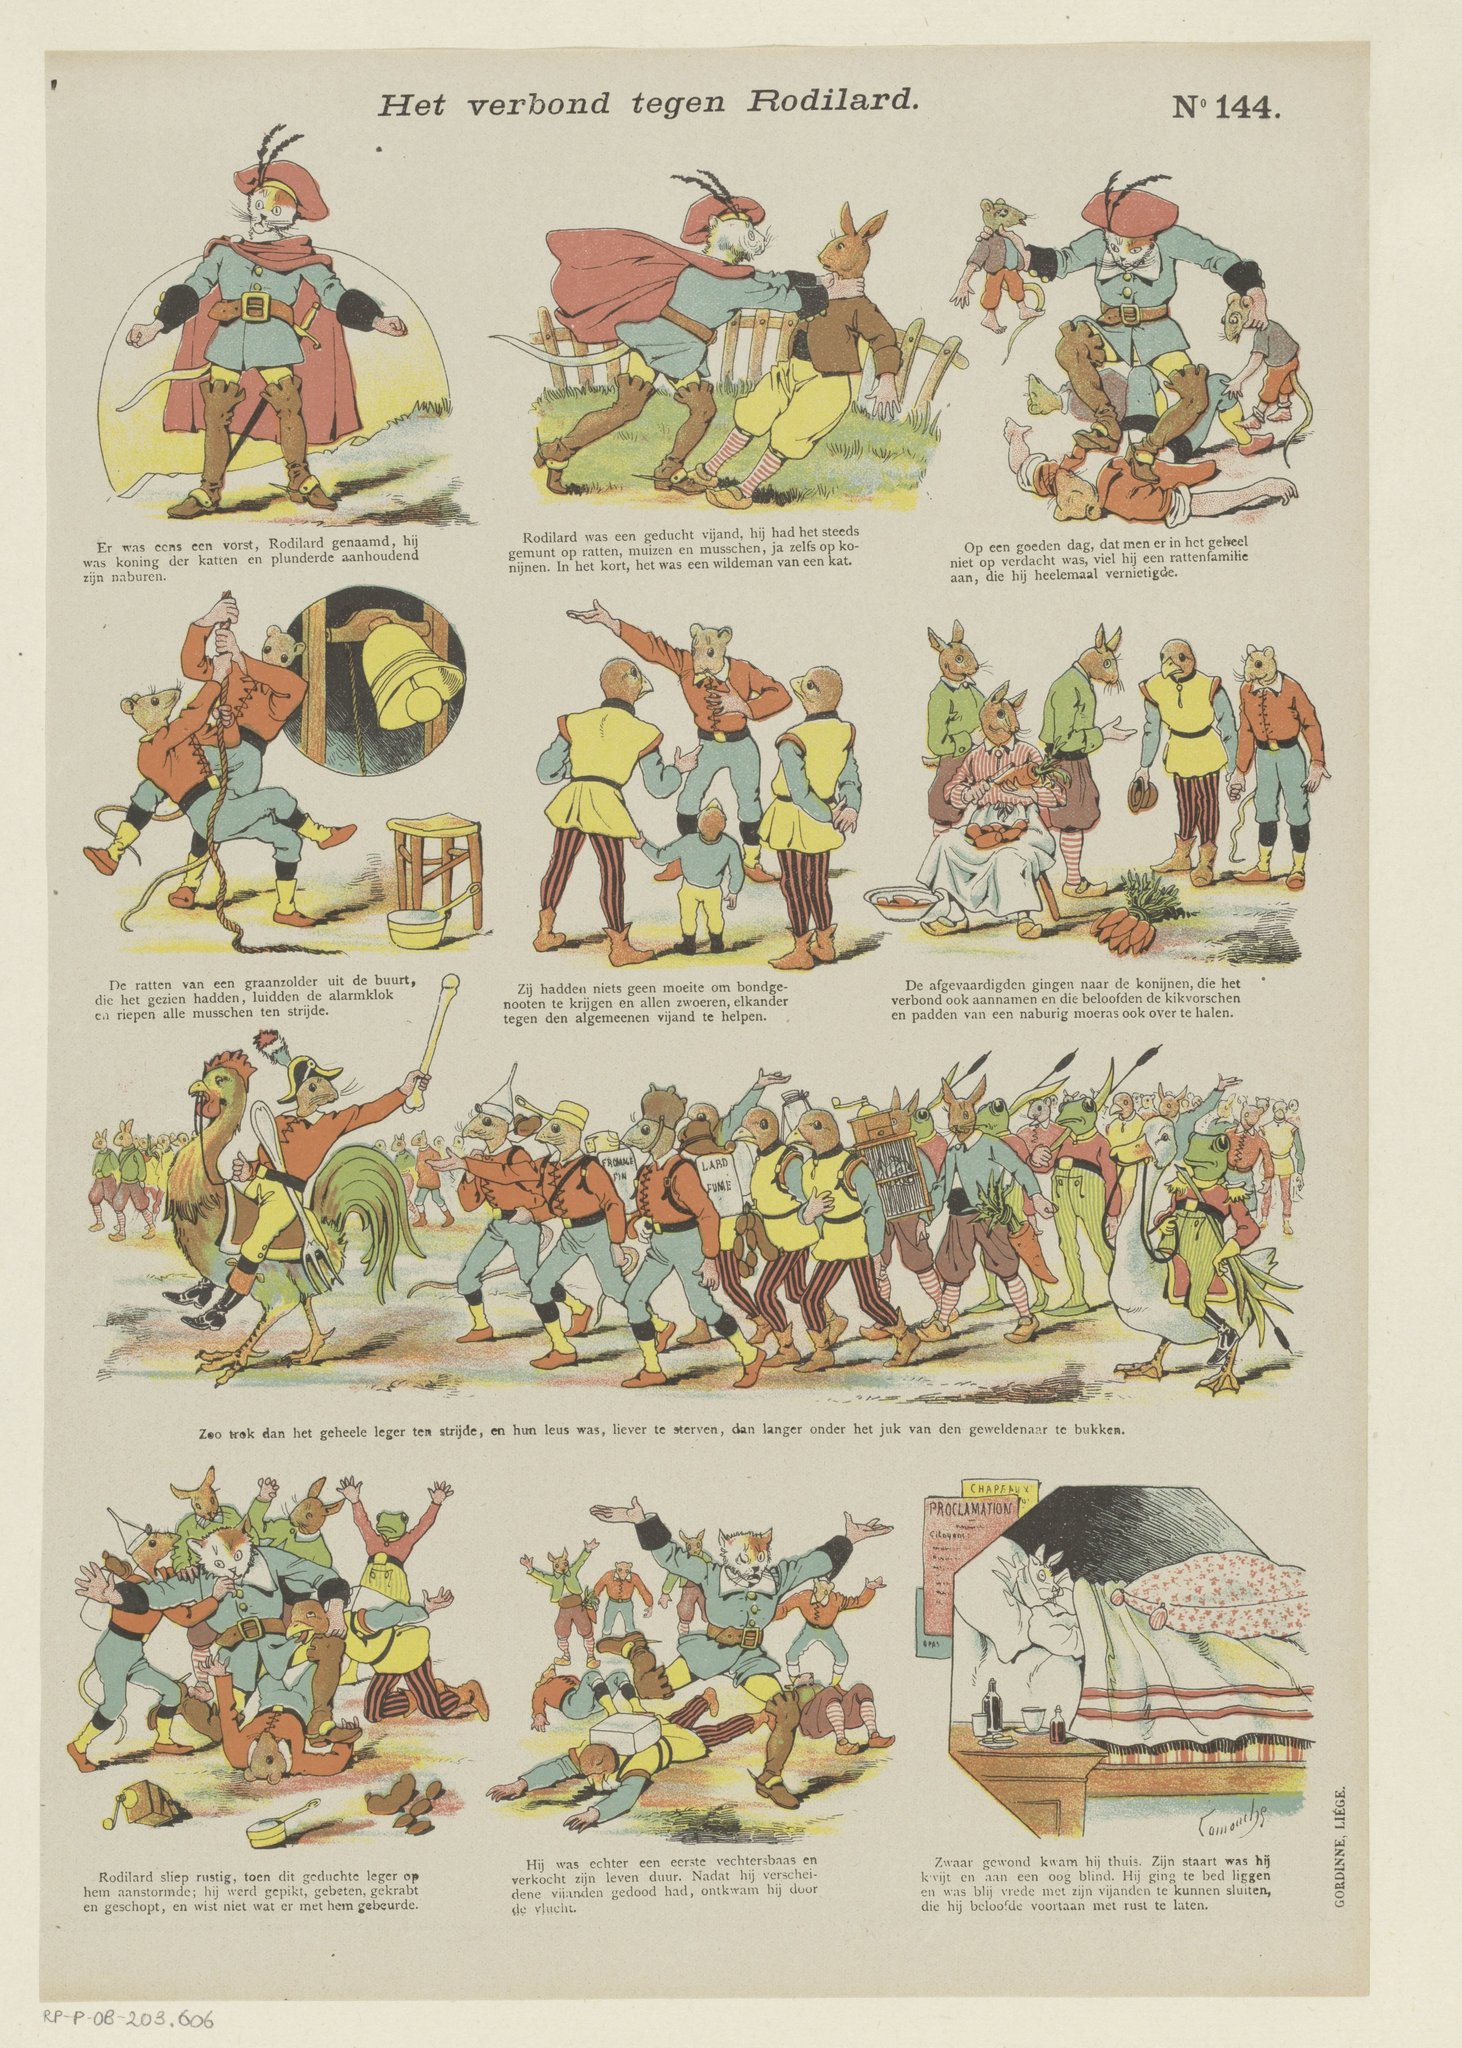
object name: popular print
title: Het verbond tegen Rodilard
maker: lamouche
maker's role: print maker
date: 1894-1959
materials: paper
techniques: lithograph, letterpress printing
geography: liège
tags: rodents: rat, cat, animals acting as human beings, battle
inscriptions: collector's mark: Lugt 2760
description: Blad met 10 voorstellingen over de ratten die in opstand komen tegen Rodilard, de koning der katten. Onder elke afbeelding een onderschrift. Genummerd rechtsboven: No 144.